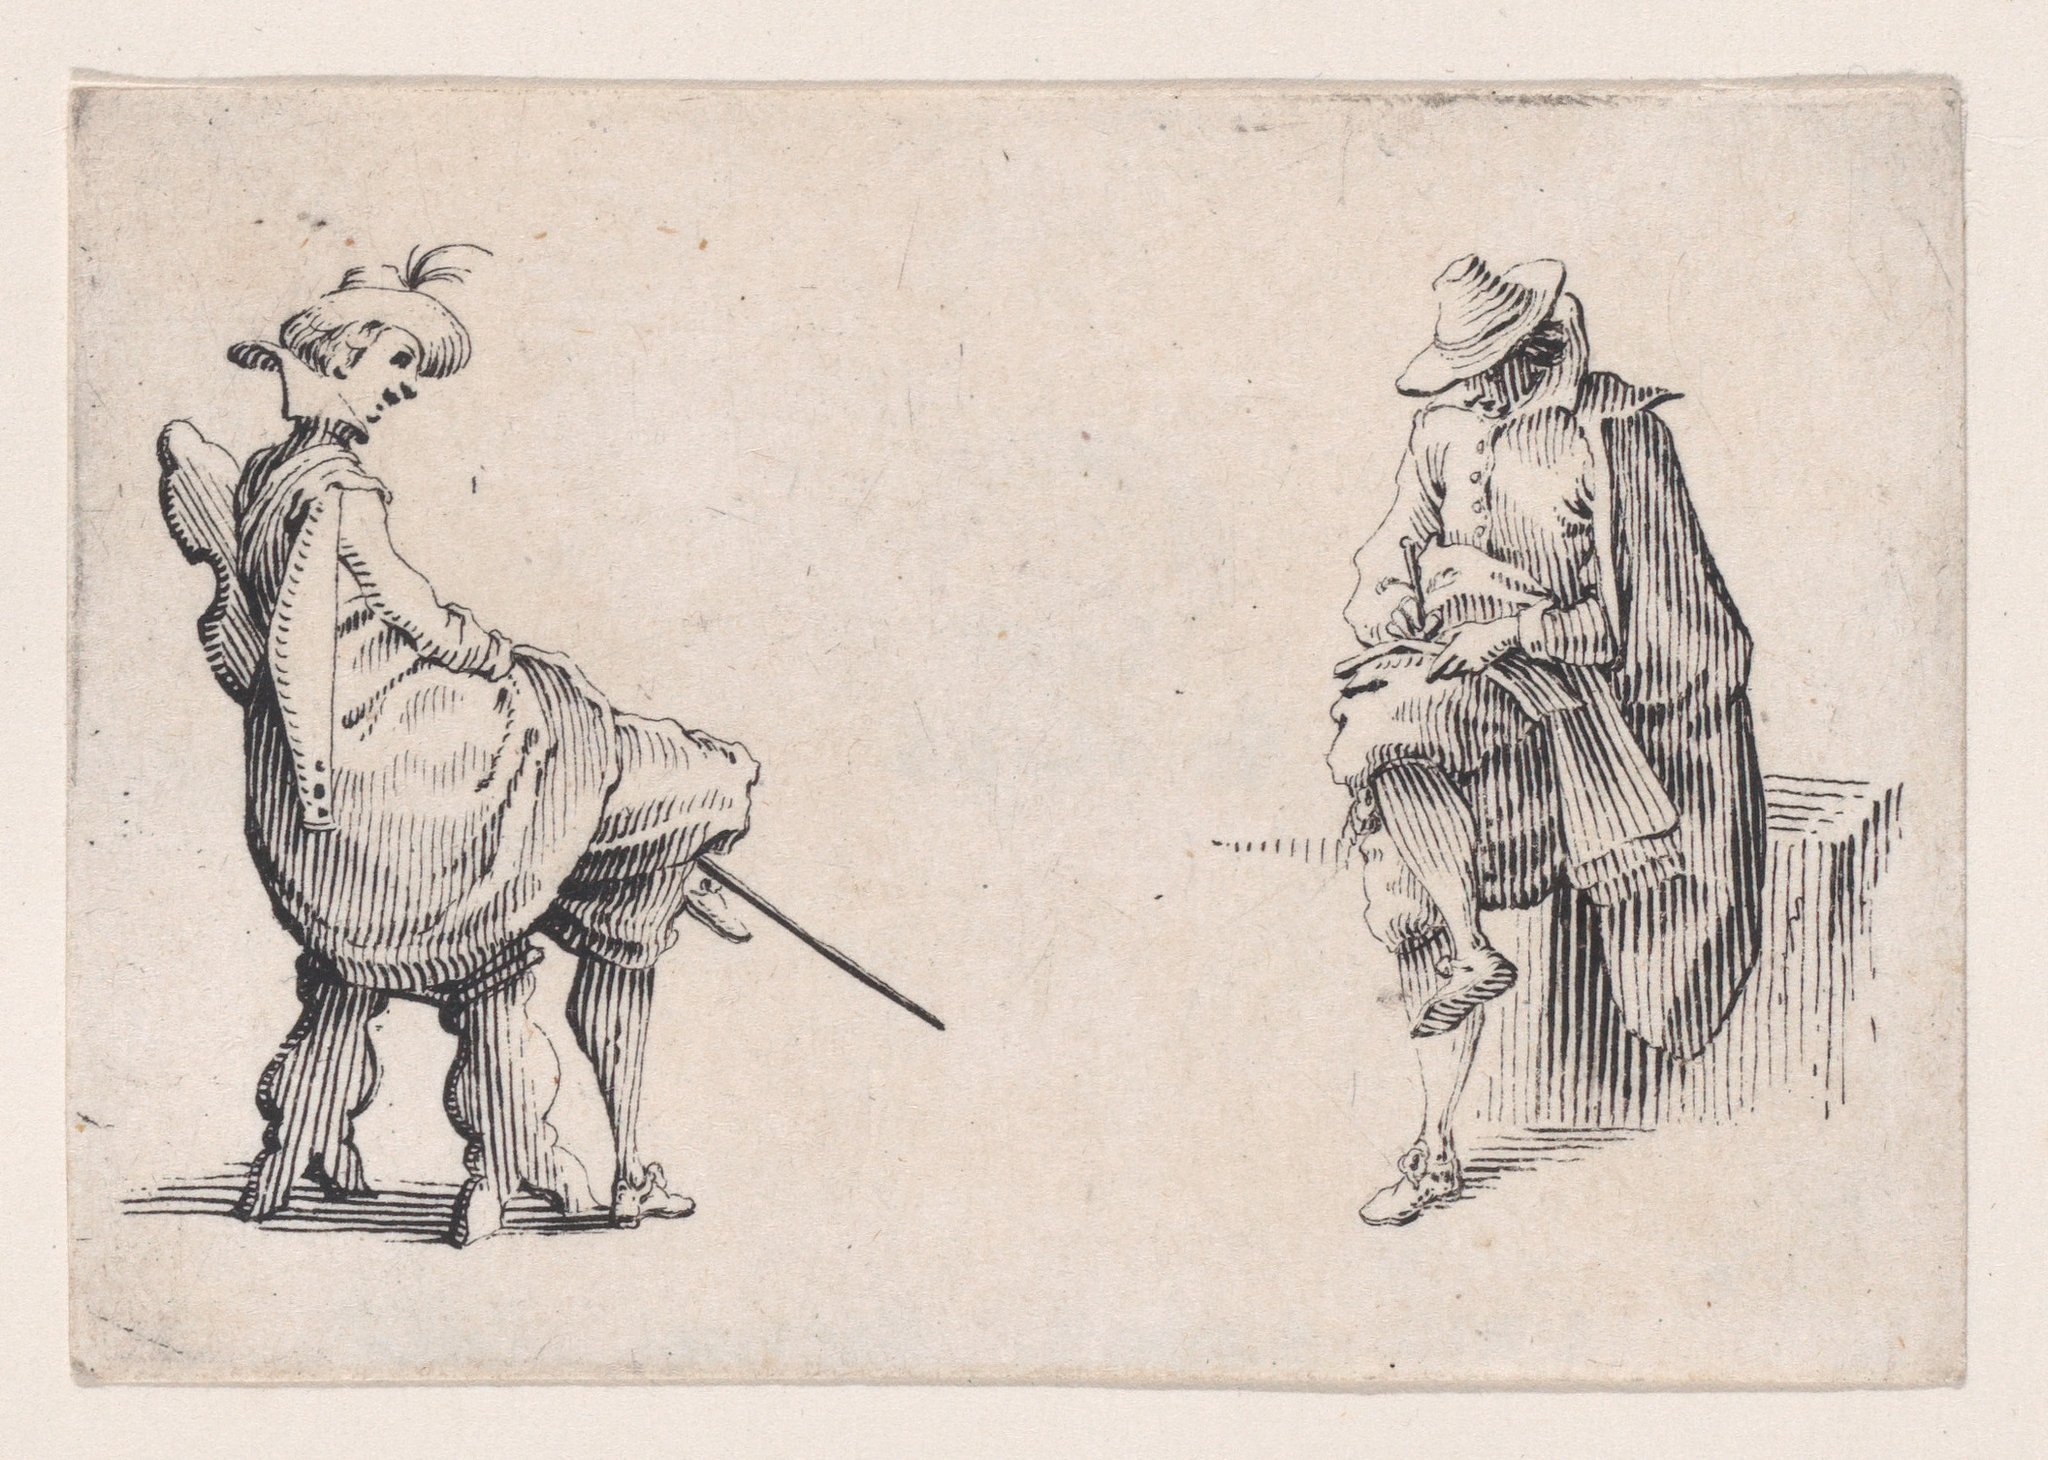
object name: print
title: Deux Personnages Assis (Two Seated Figures), from "Les Caprices" Series A, The Florence Set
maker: jacques callot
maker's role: artist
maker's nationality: french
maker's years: 1592-1635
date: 1617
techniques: etching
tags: men